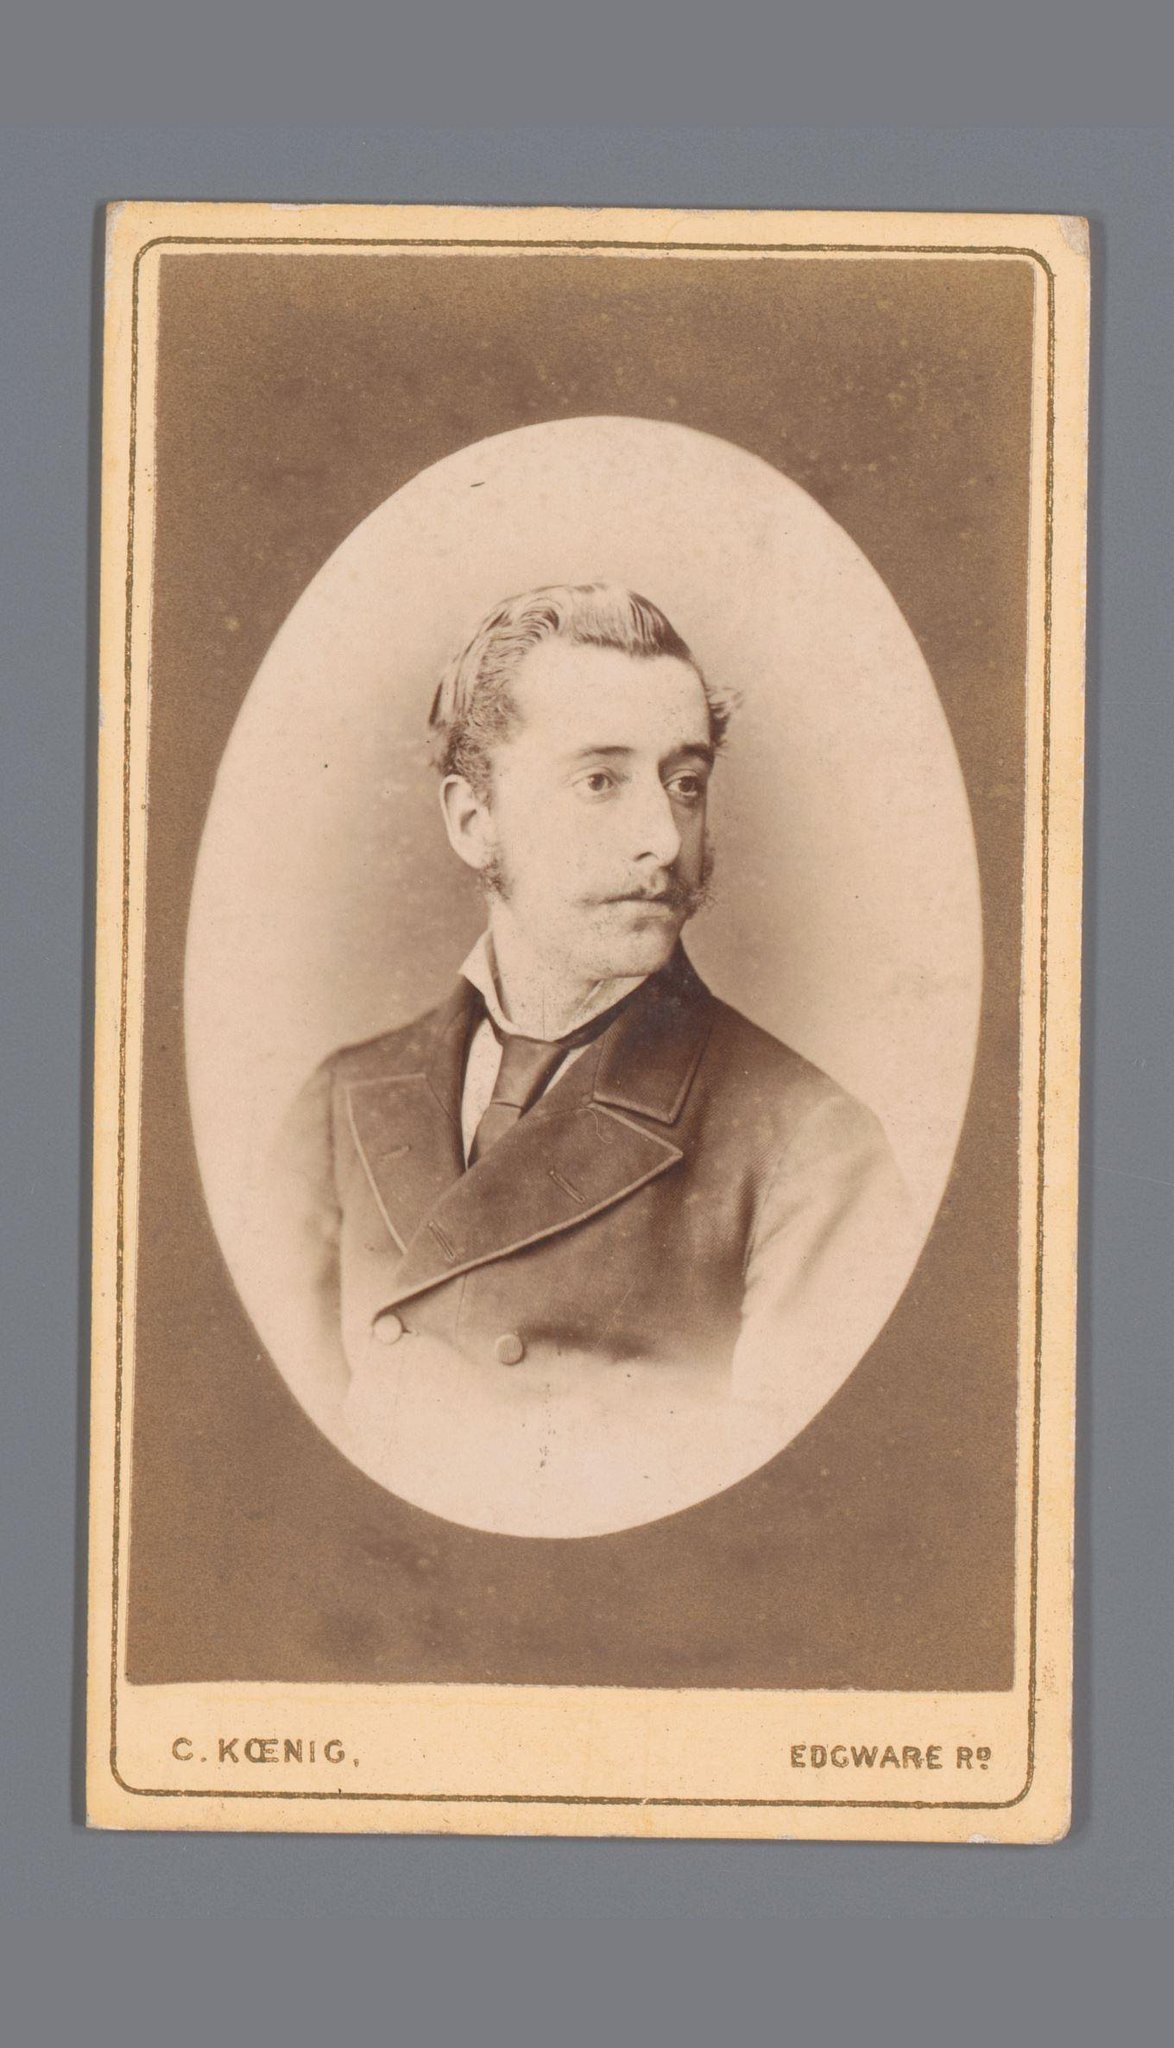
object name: photograph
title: Portret van een onbekende man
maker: charles james christopher koenig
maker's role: fotograaf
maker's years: 1843-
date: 1878-1885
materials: cardboard, paper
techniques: albumen print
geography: london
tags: adult man, anonymous historical person portrayed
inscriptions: address: ‘373, Edgware Road, Maida Vale,/ nearly opposite princess st.’, inscription: ‘COPIES MAY BE HAD AND ENLARGED/ FINISHED IN OIL OR WATER.’